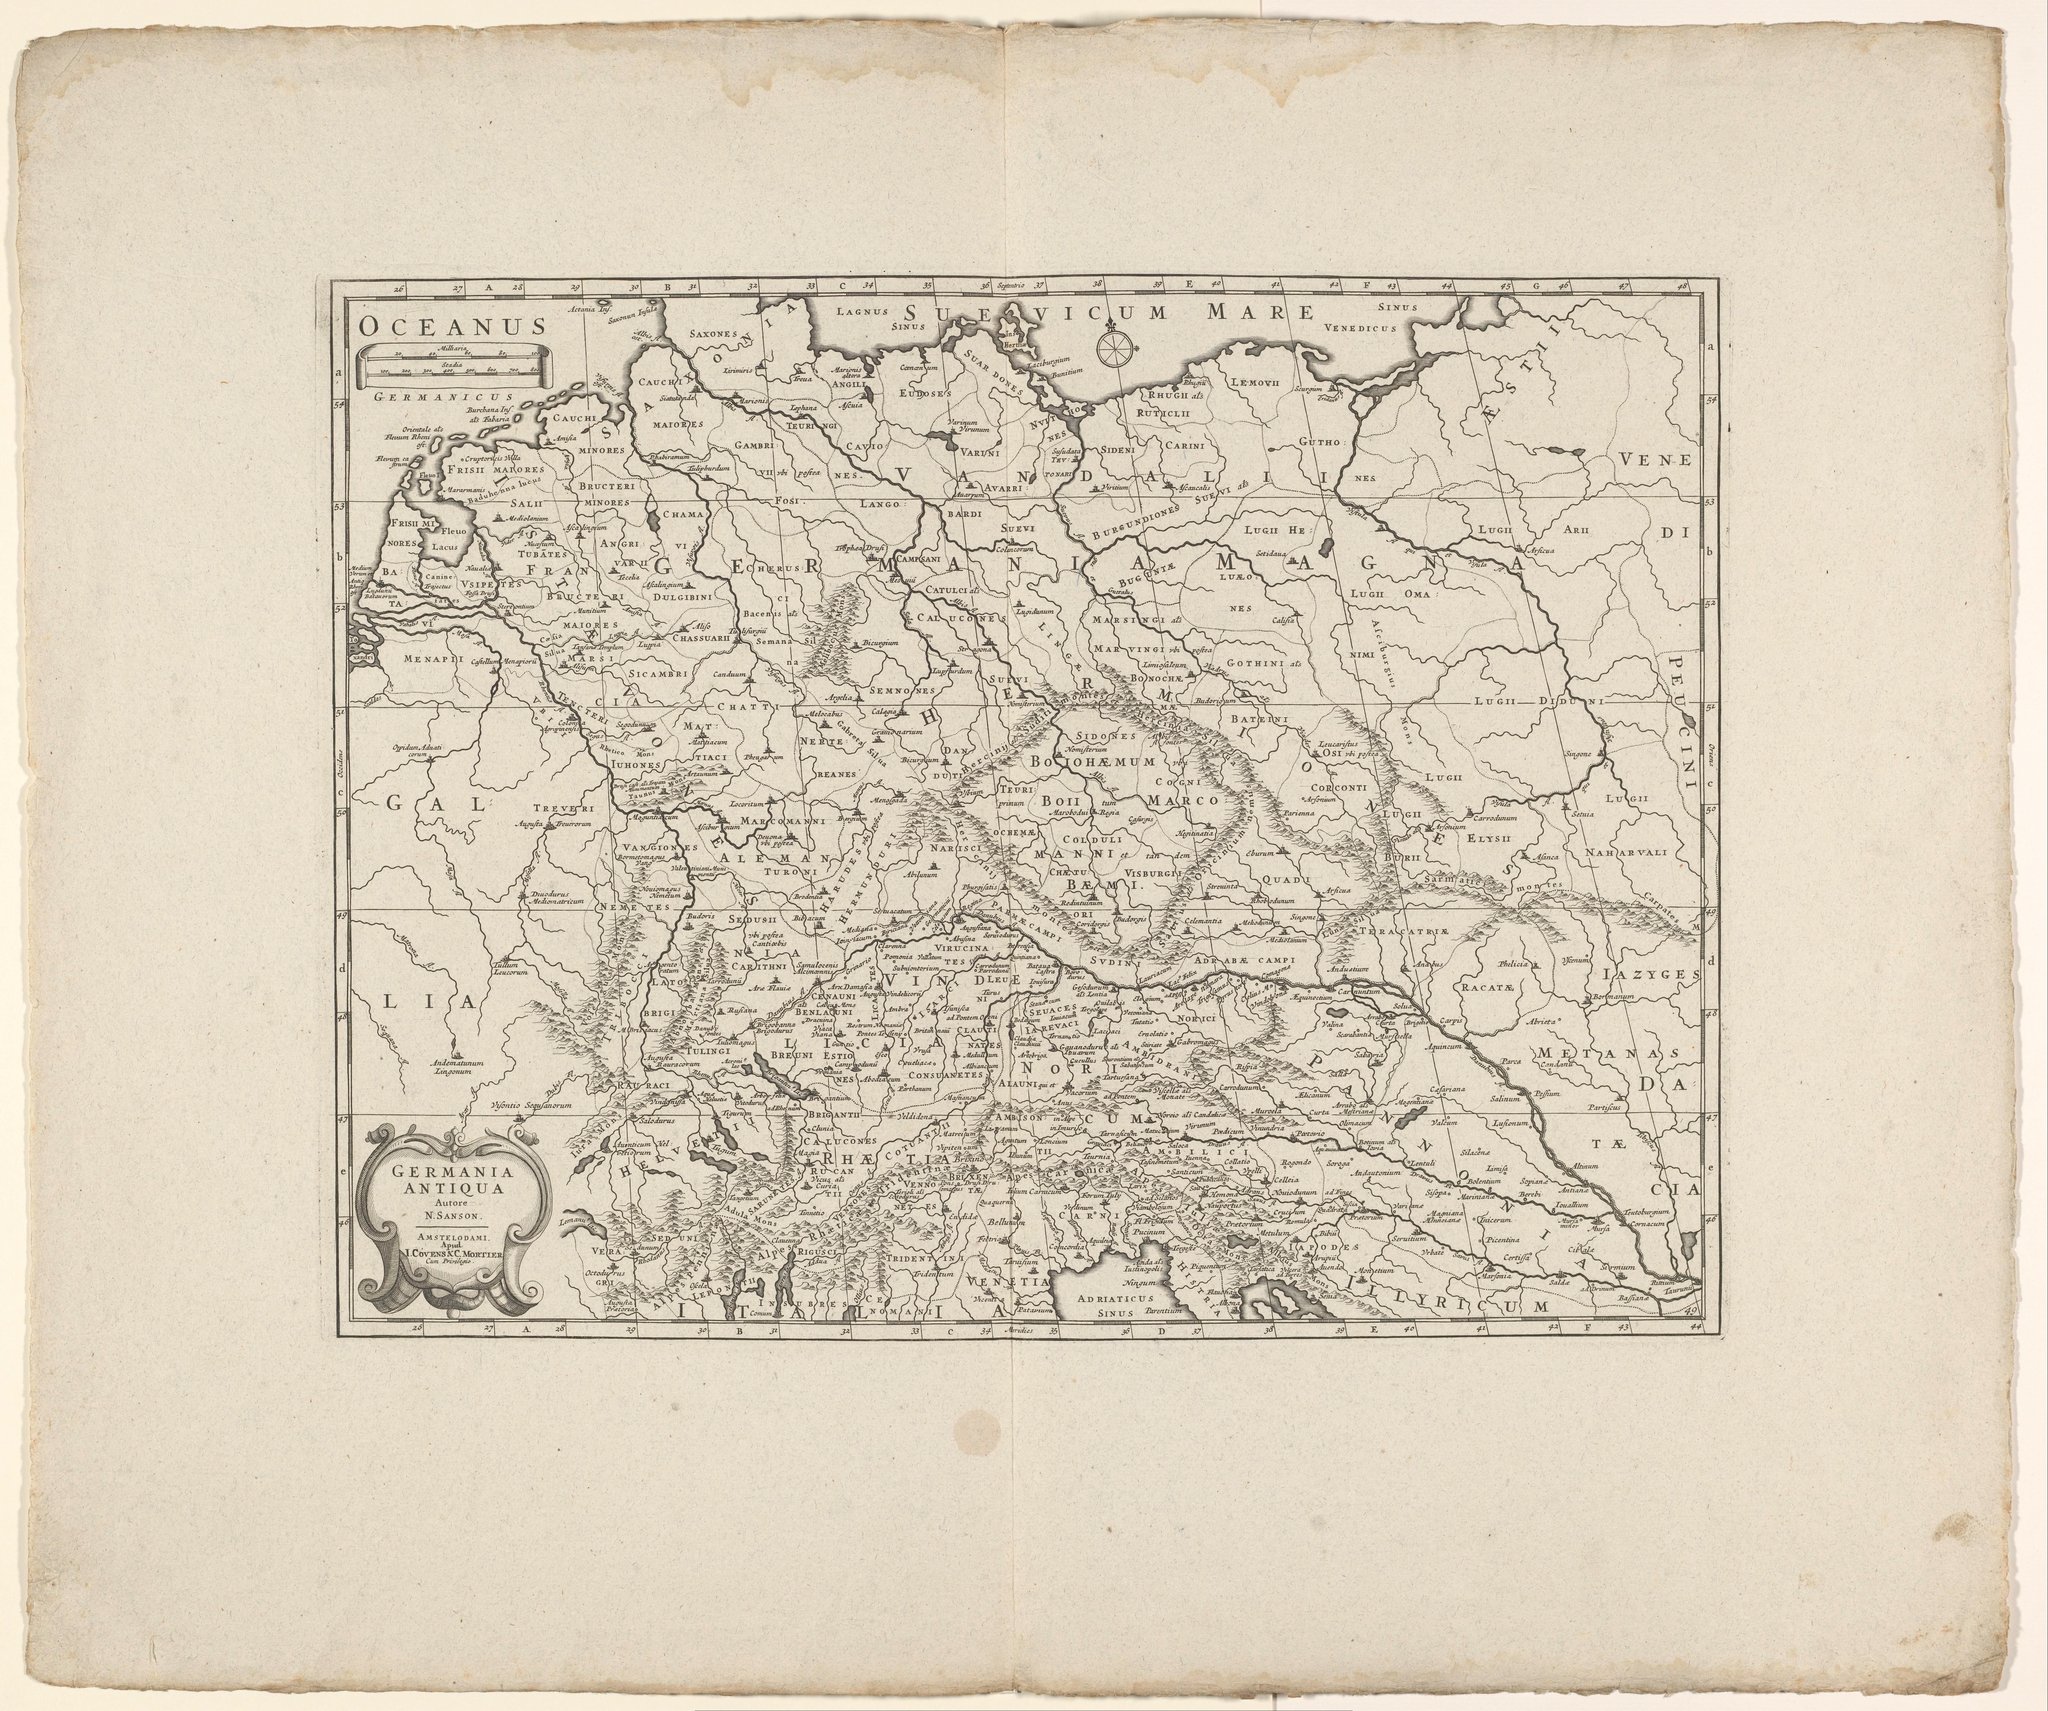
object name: print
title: Kaart van Duitsland in de Romeinse tijd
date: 1721-1774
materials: paper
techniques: engraving, etching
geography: amsterdam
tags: maps of separate countries or regions, germany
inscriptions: collector's mark: Lugt 1641a, collector's mark: Lugt 2228